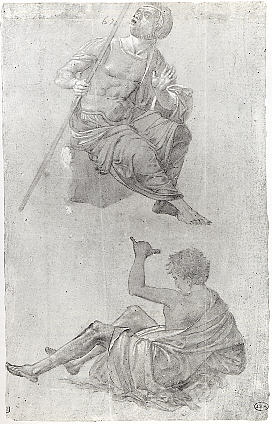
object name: drawing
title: The Flagellation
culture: italian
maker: italian, veneto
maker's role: artist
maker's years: 1500-1535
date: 1501-1533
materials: paper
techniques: brush, wash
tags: men,christ